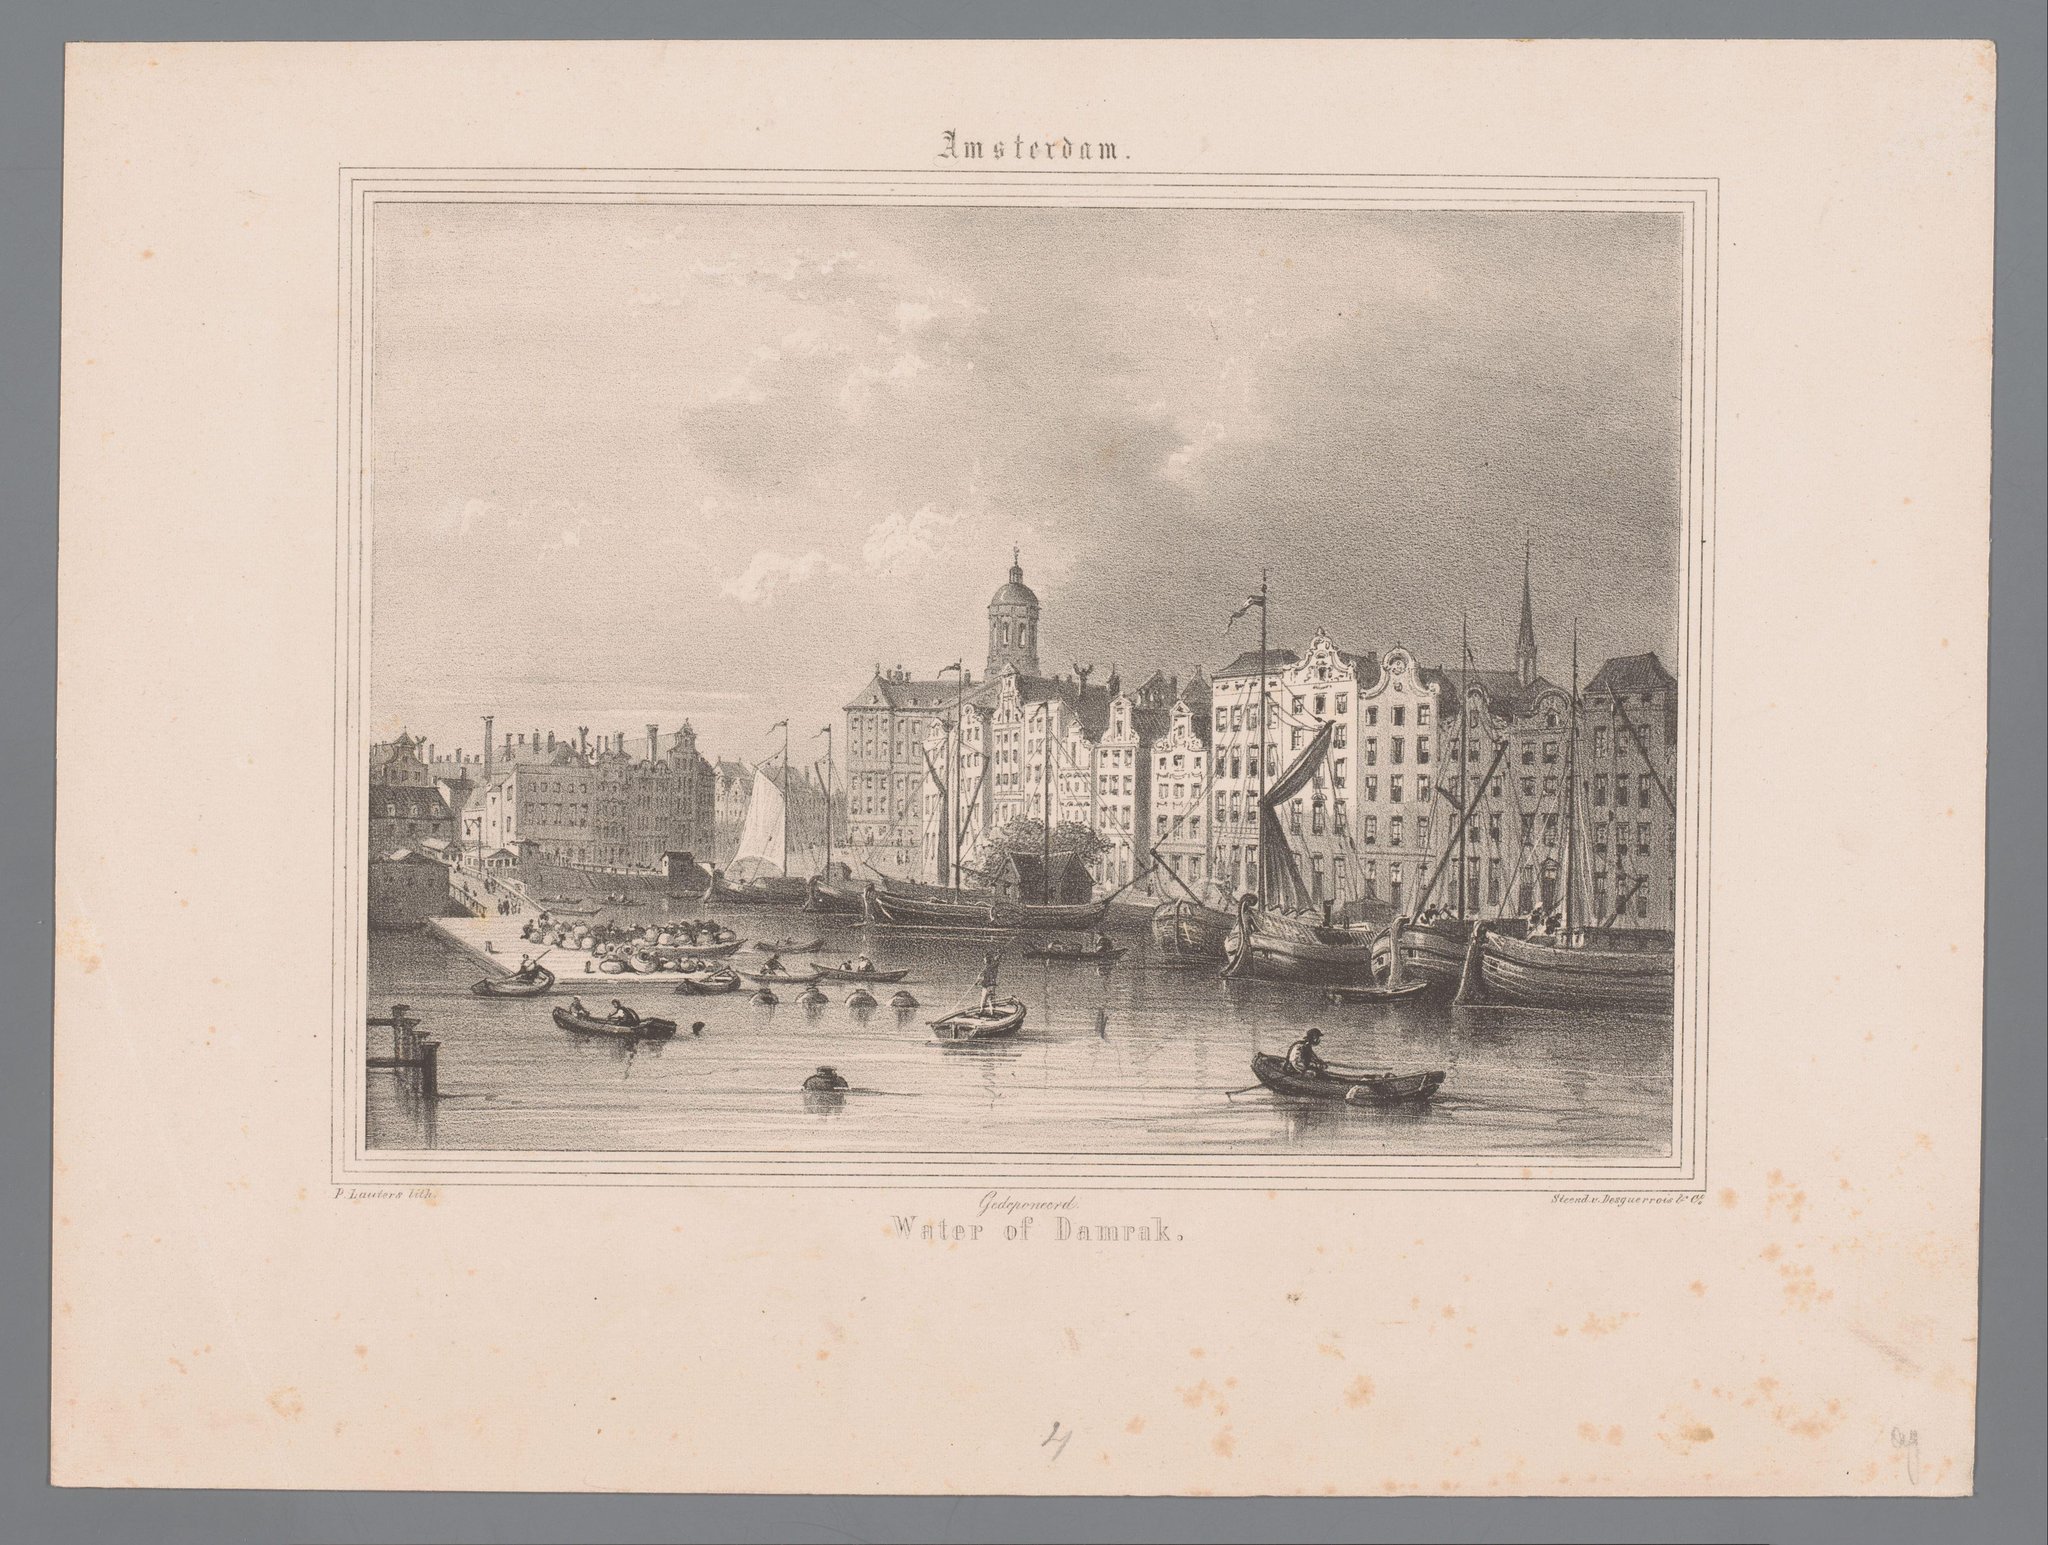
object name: print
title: Amsterdam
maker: paulus lauters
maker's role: print maker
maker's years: 1806-1875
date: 1836-1840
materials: paper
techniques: lithograph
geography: amsterdam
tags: city-view in general; 'veduta'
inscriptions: collector's mark: Lugt 2228, : ‘Gedeponeerd.’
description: Prent maakt onderdeel uit van de serie: Hoofdgebouwen en gezichten der Voornaamste Steden van Holland. Onder deze naam werden in ieder geval verschillende stadgezichten gepubliceerd in de jaren 1836, 1839 en 1840 door Desguerrois & Co.